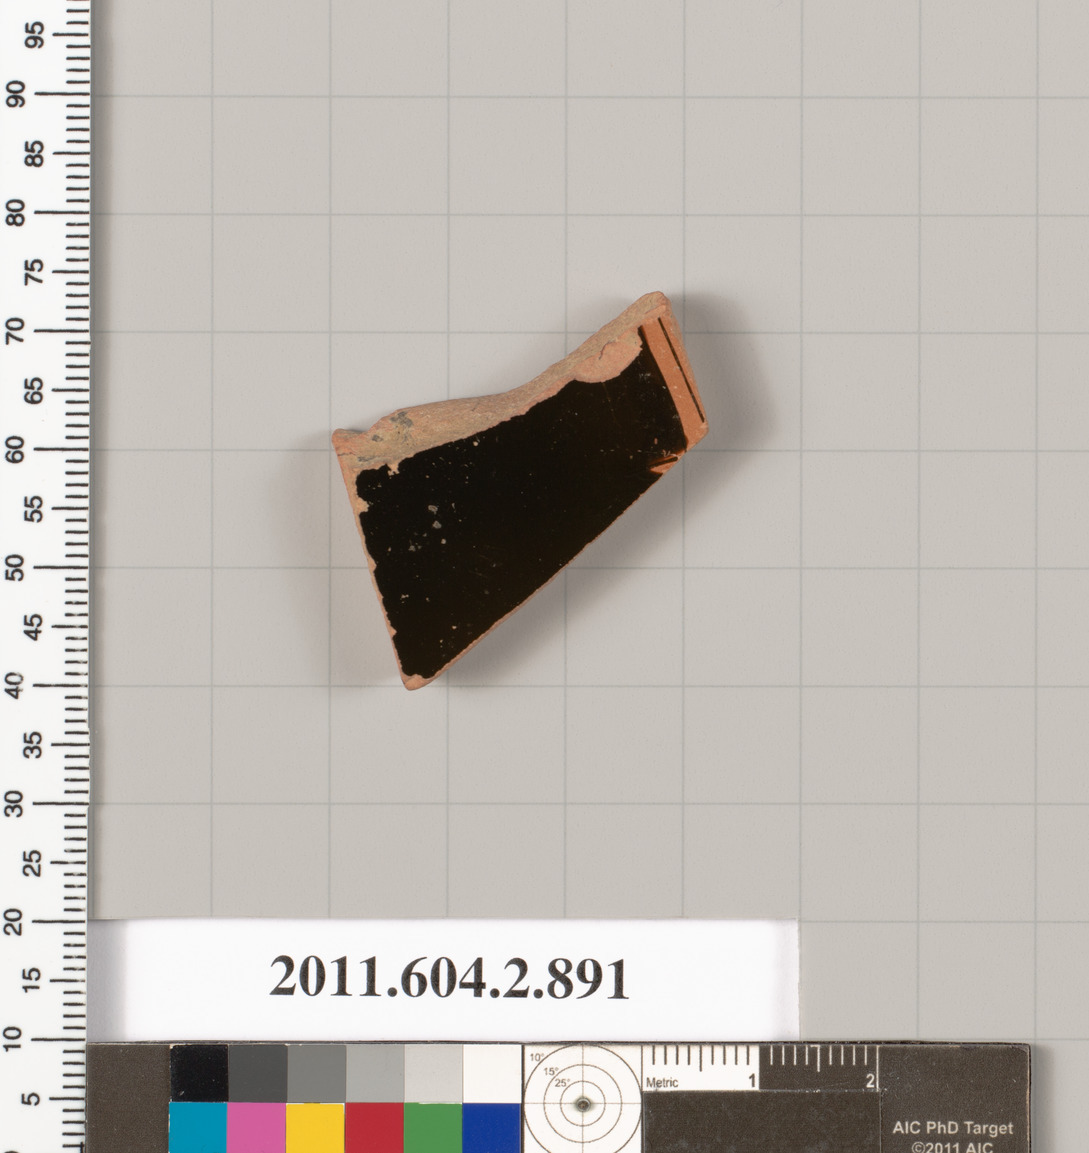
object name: bell krater fragment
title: Terracotta fragment of a bell-krater (bowl for mixing wine and water)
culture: greek, attic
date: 470-450 BCE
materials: terracotta